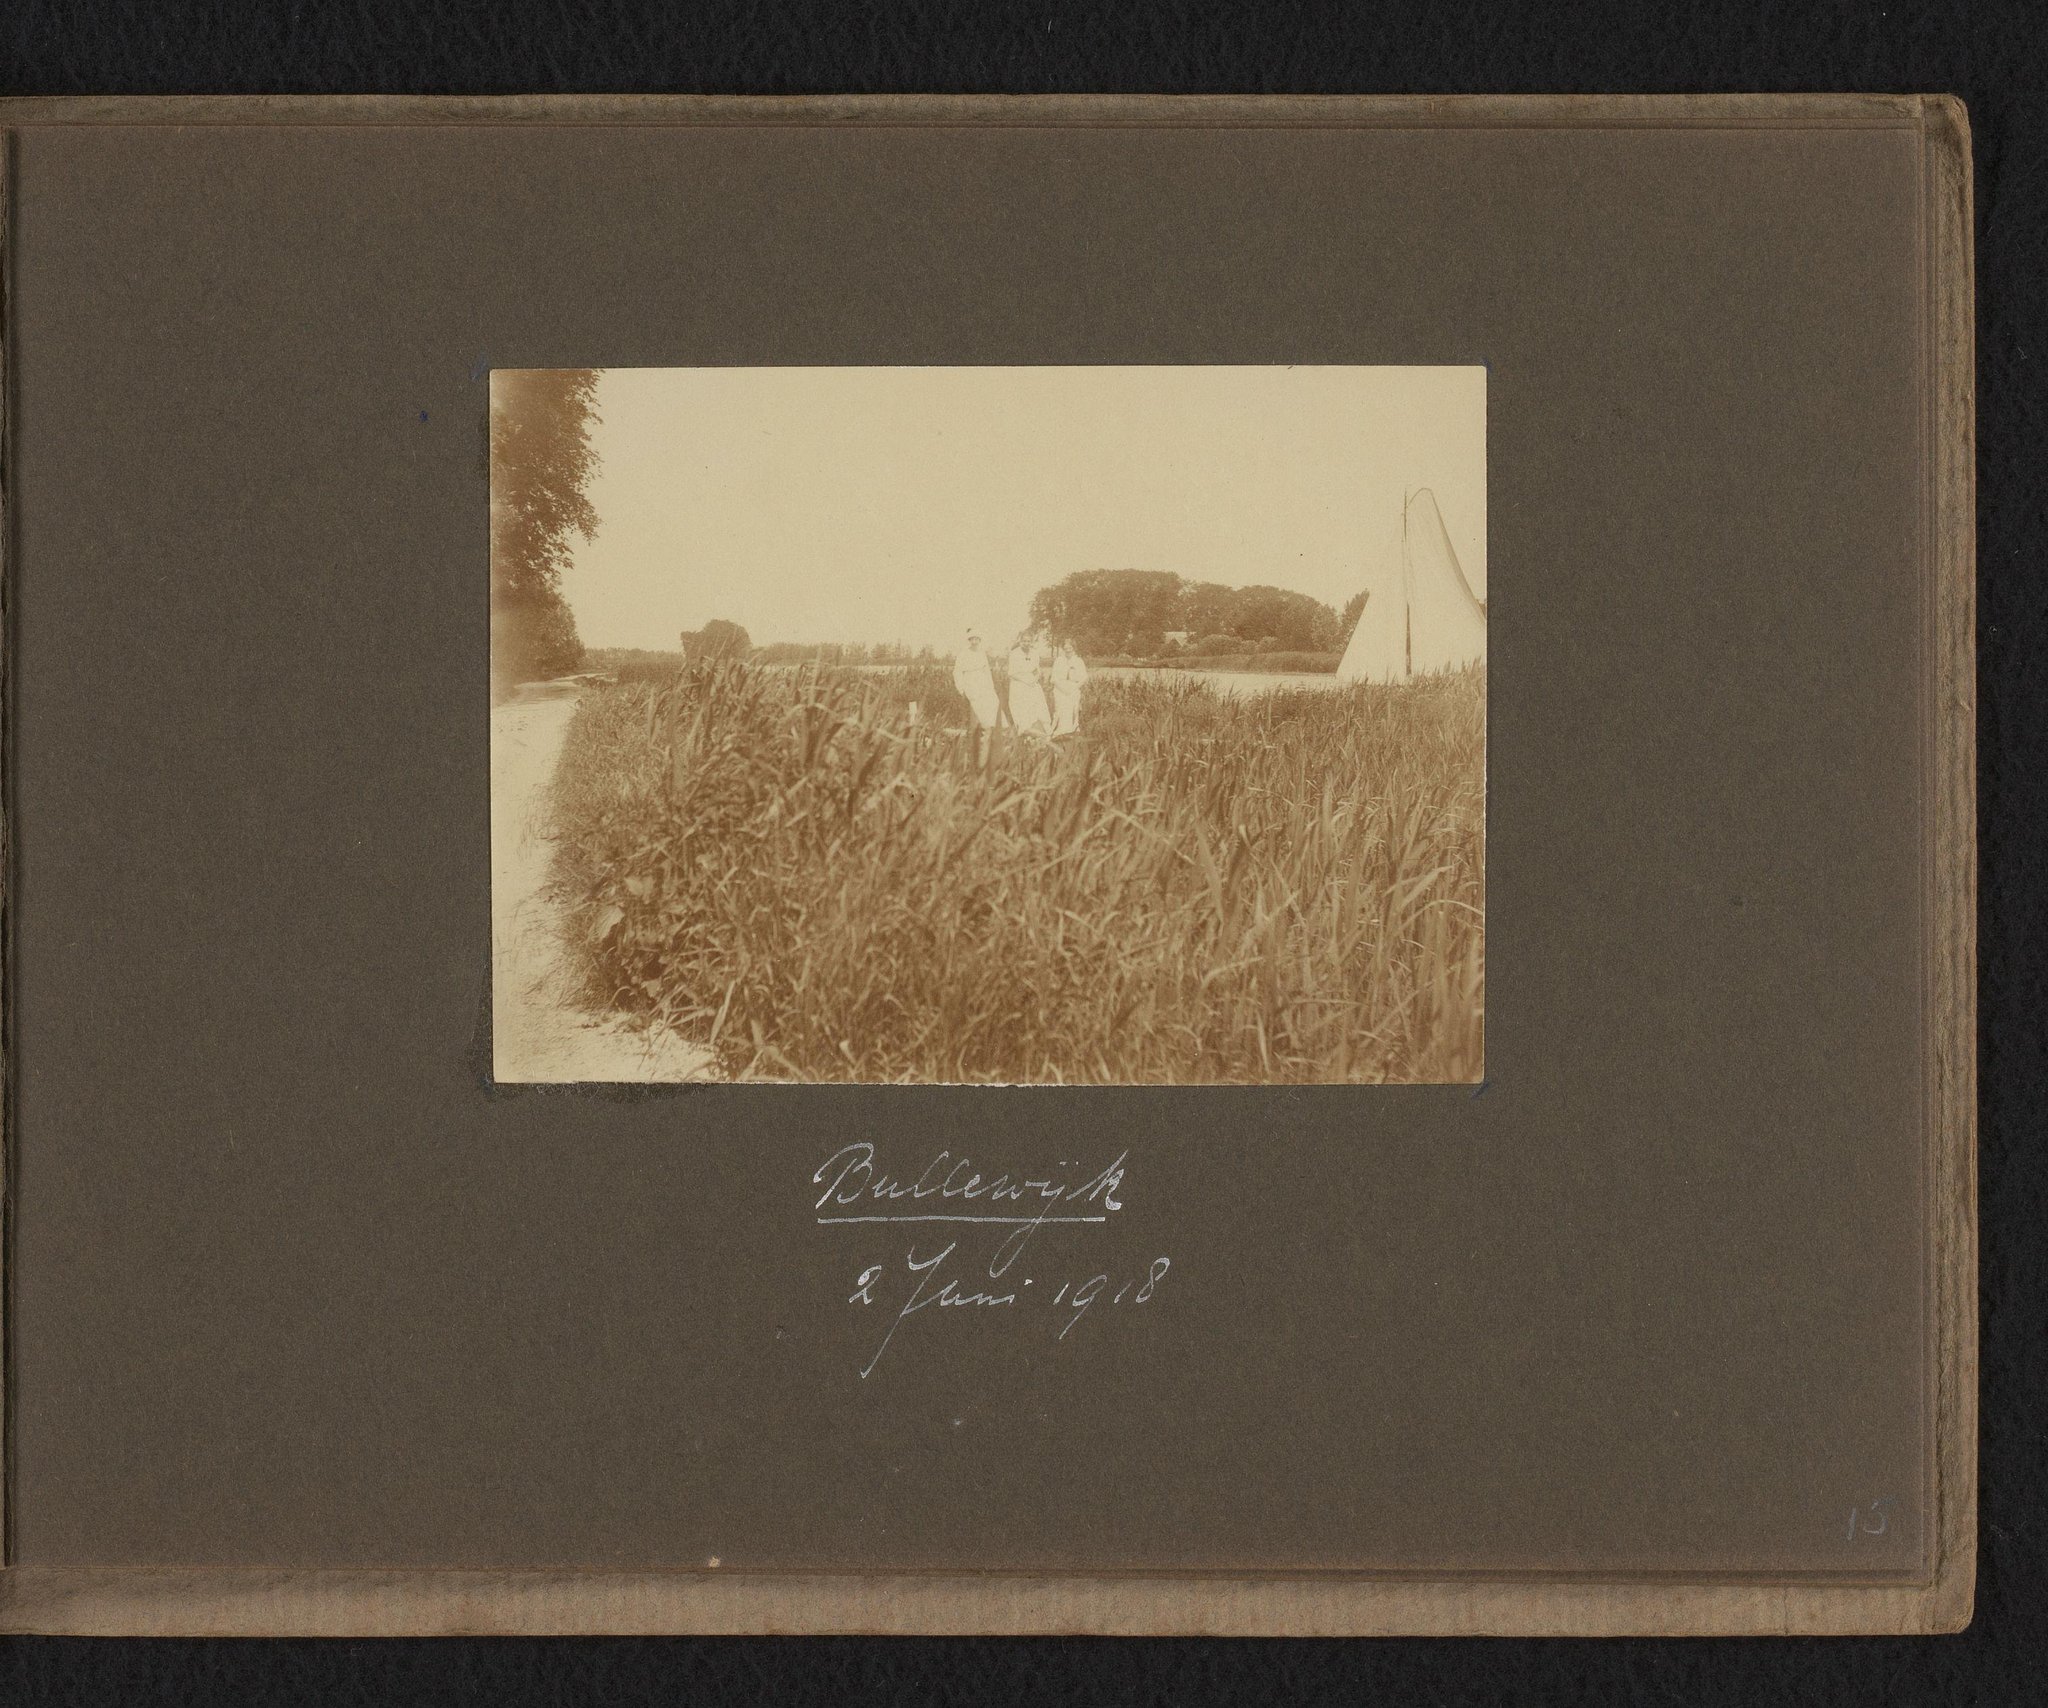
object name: photograph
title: Drie vrouwen tussen het riet langs de Bullewijk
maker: Anonymous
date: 1918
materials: paper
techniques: matte daylight collodion silver print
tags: sailing-ship, sailing-boat, river, plants and herbs: reed, adult woman (+ three persons)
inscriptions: caption: ‘Bullewijk’